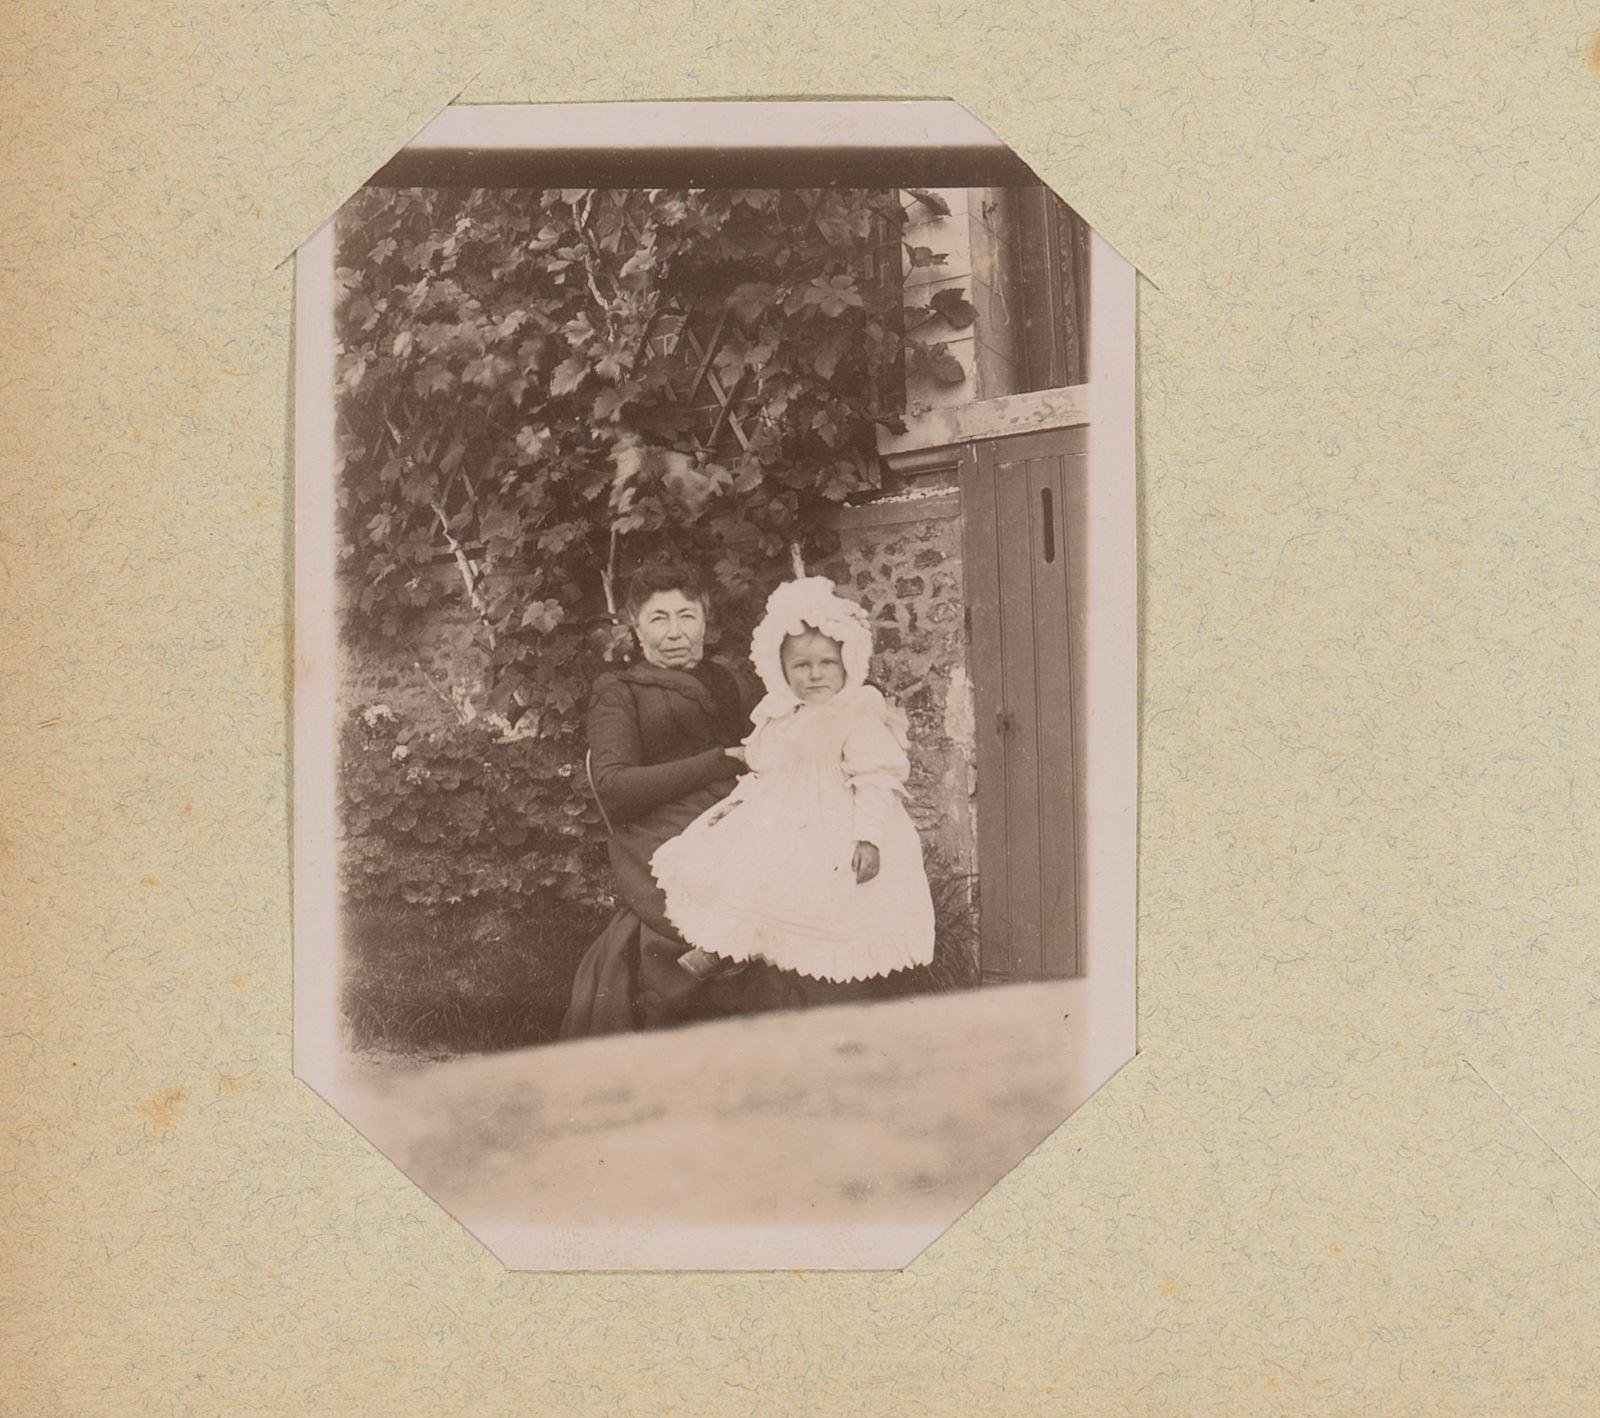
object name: photograph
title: Portret van een vrouw en een kind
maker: Anonymous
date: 1897-1900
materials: paper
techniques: gelatin silver print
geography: france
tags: child, historical persons, old woman, france